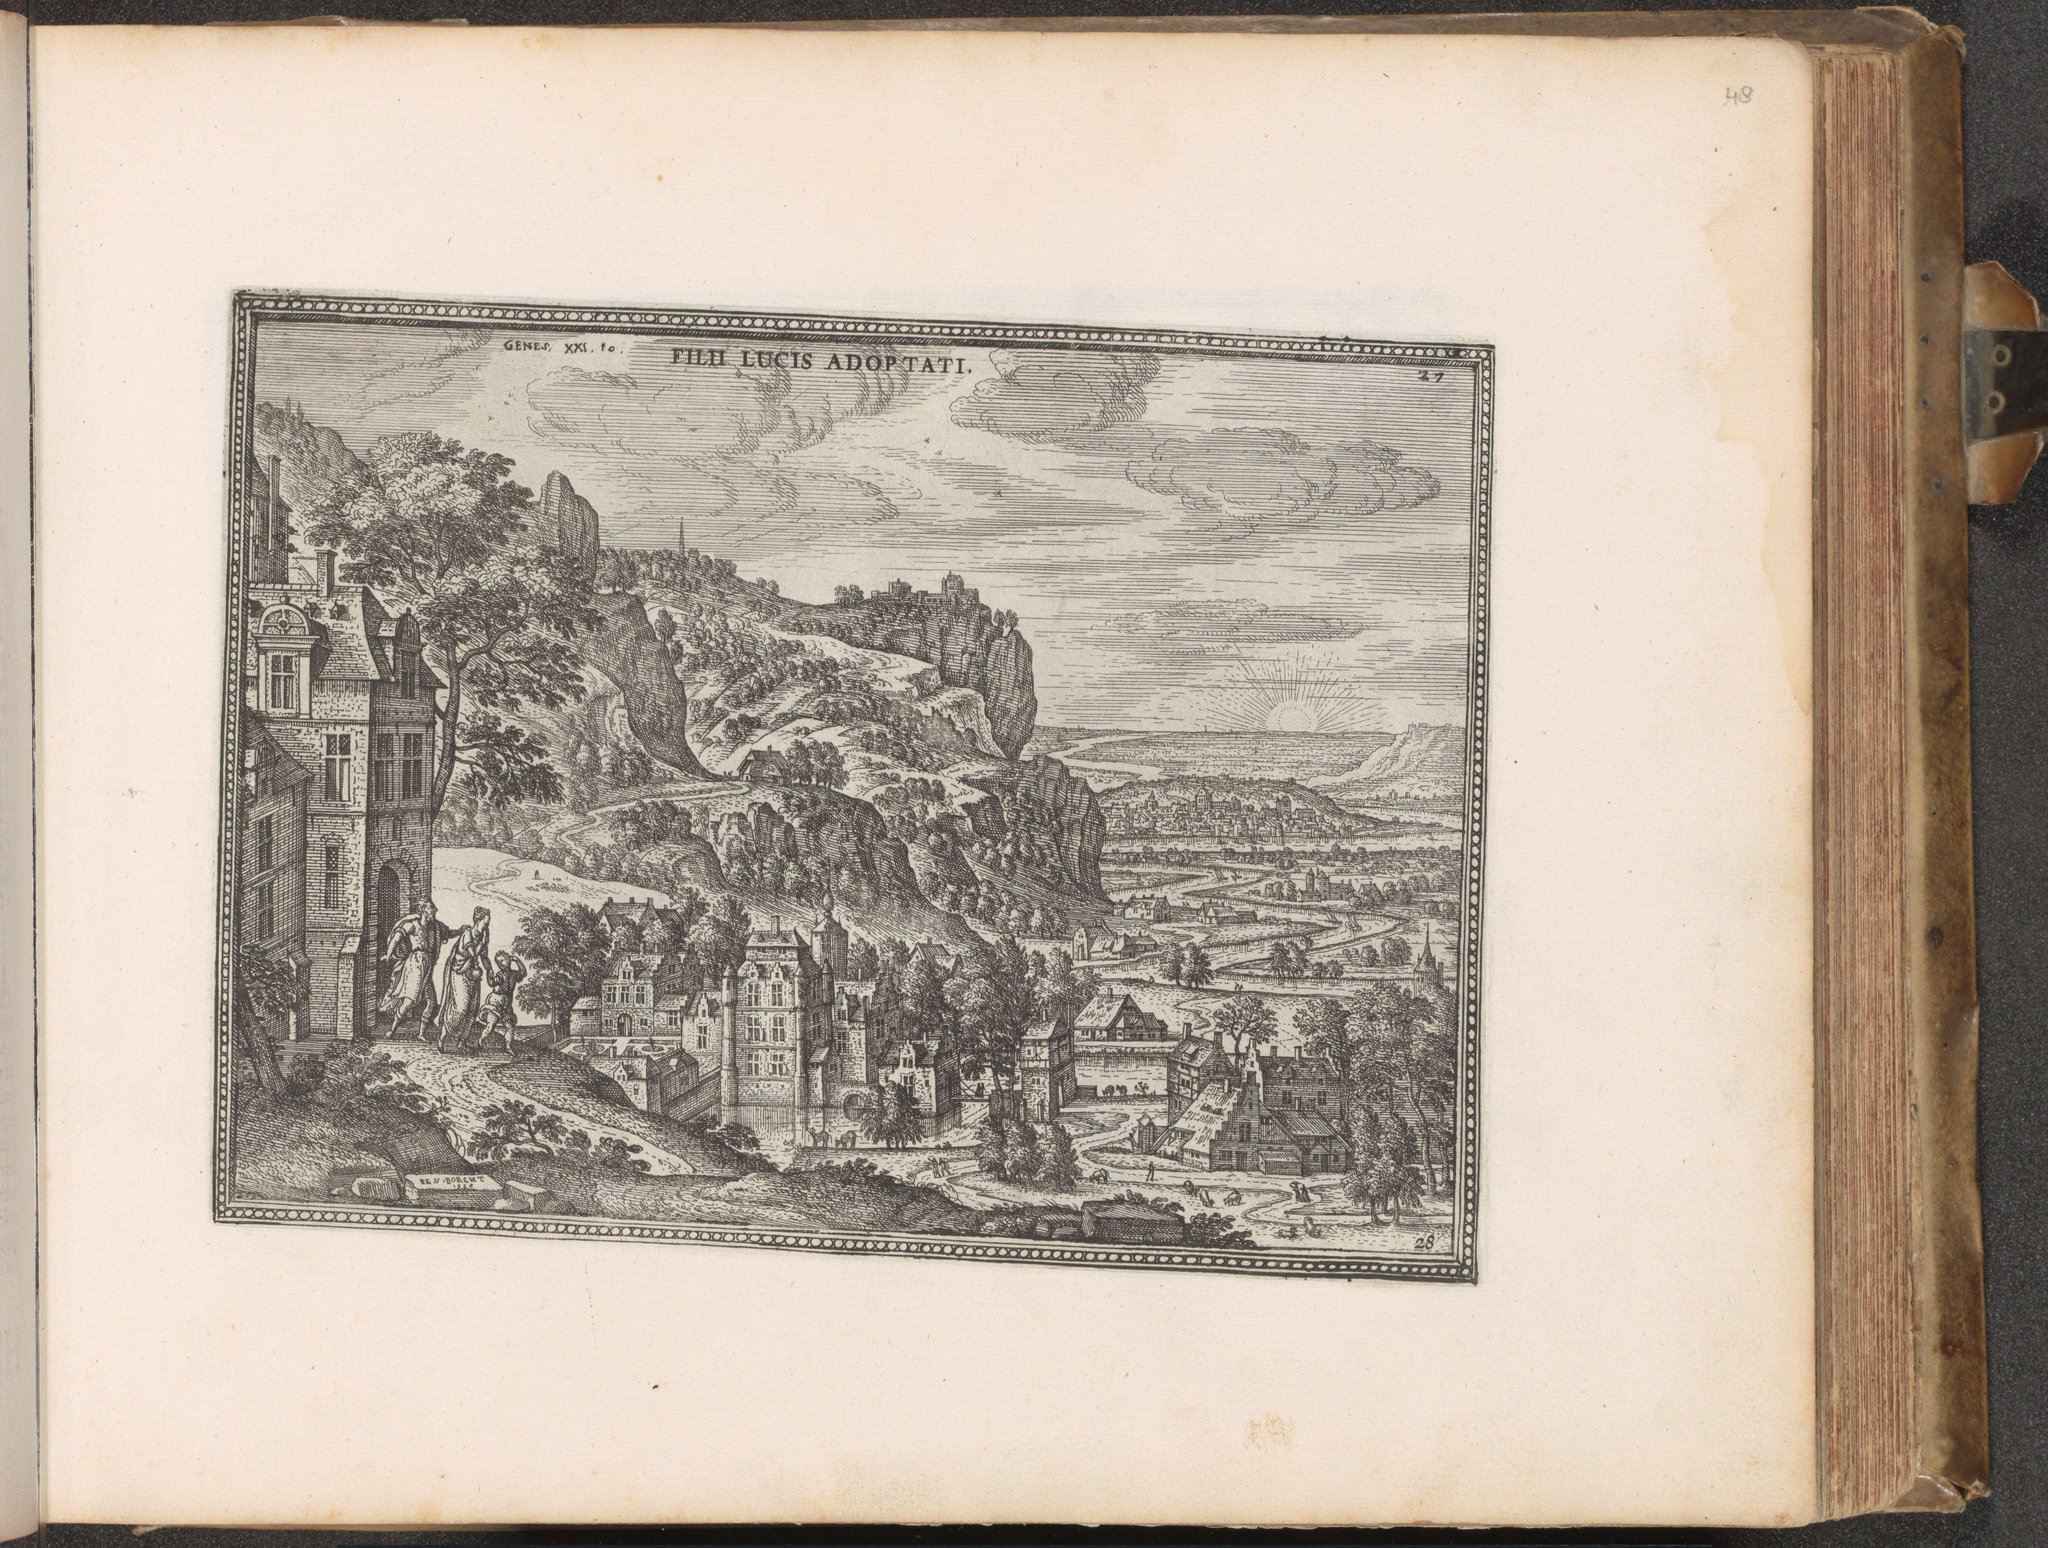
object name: print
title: Landschap met de verdrijving van Hagar en Ismaël door Abraham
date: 1582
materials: paper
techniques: etching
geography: amsterdam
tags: city-view, and landscape with man-made constructions, landscapes, river, the banishment of hagar and ishmael (genesis 21:9-21), old testament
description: Rivierlandschap met huizen. In de verte de zee met opkomende zon. Links stuurt Abraham Hagar en zijn eerste zoon Ismaël weg op verzoek van zijn vrouw Sara (Gen. 21:10). De prent maakt deel uit van een album.